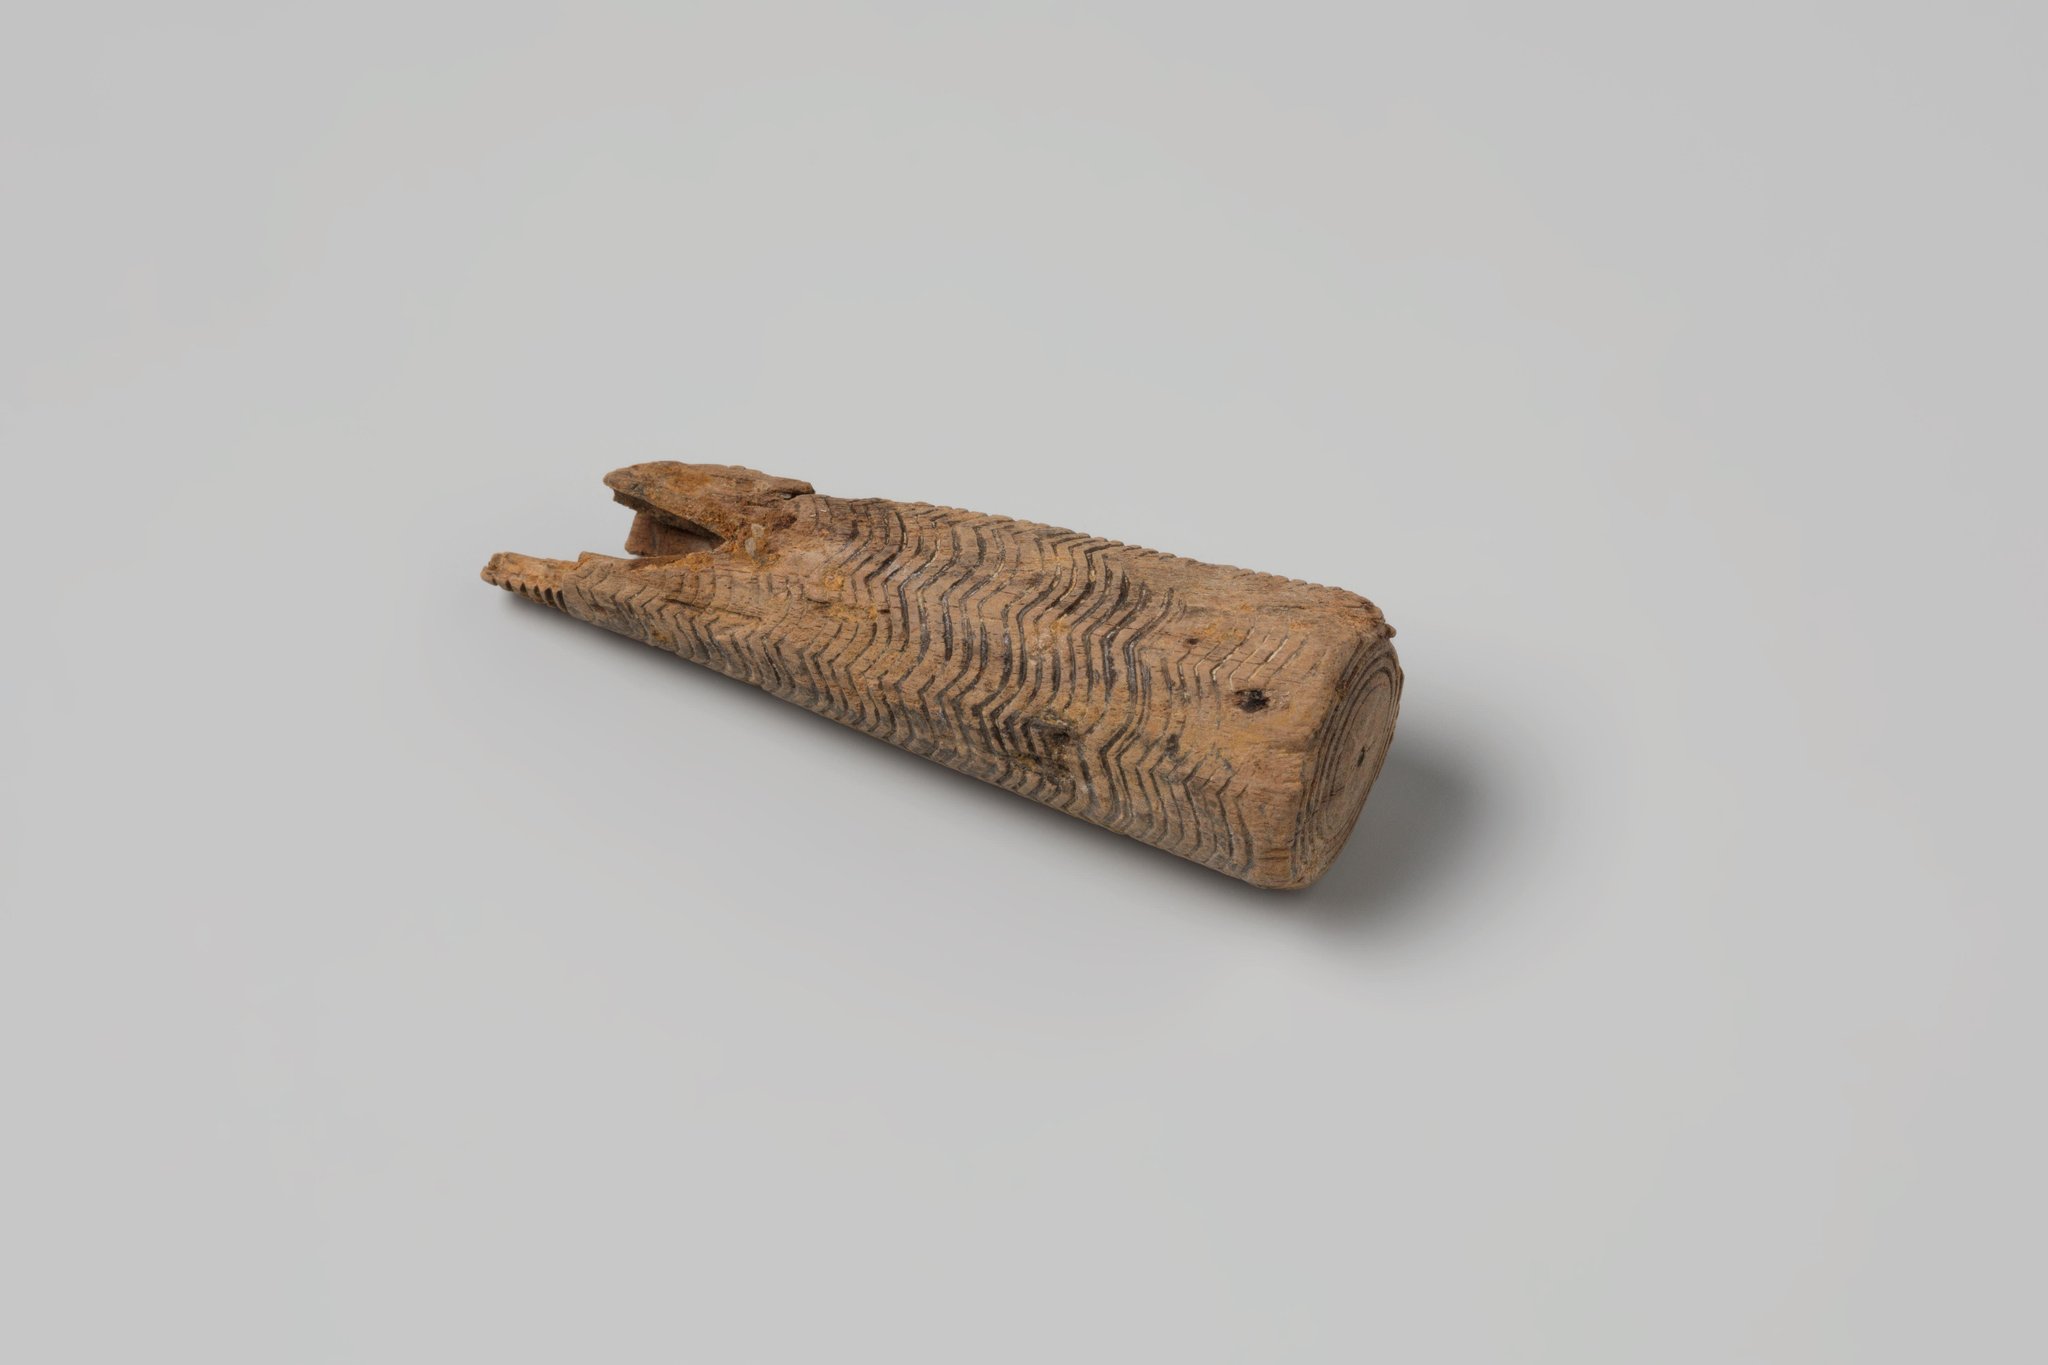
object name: knife handle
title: Messenheft uit het wrak van de Oost-Indiëvaarder Hollandia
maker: Anonymous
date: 1700-1743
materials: wood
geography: netherlands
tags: verenigde oostindische compagnie, hollandia (schip), annet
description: Knife, handle, cylindrical: tapering; fragm, lower end broken: sim. NG 1980-27H545, variation in wavy line pattern.